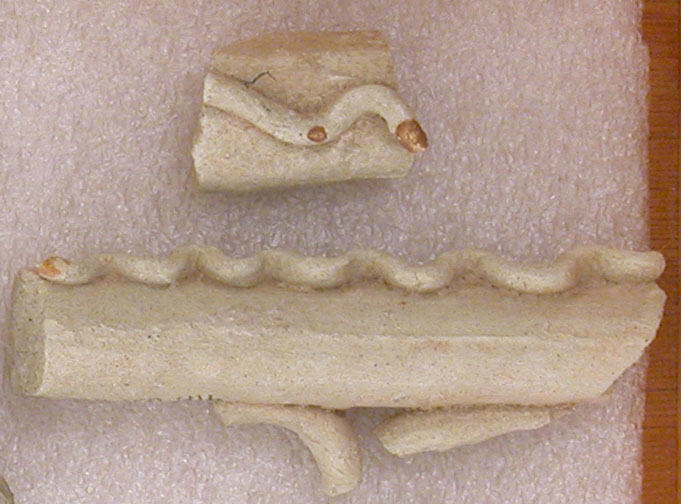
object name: fragment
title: Fragment of a Handle with Wavy Band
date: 801-1100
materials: earthenware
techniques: molding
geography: iraq